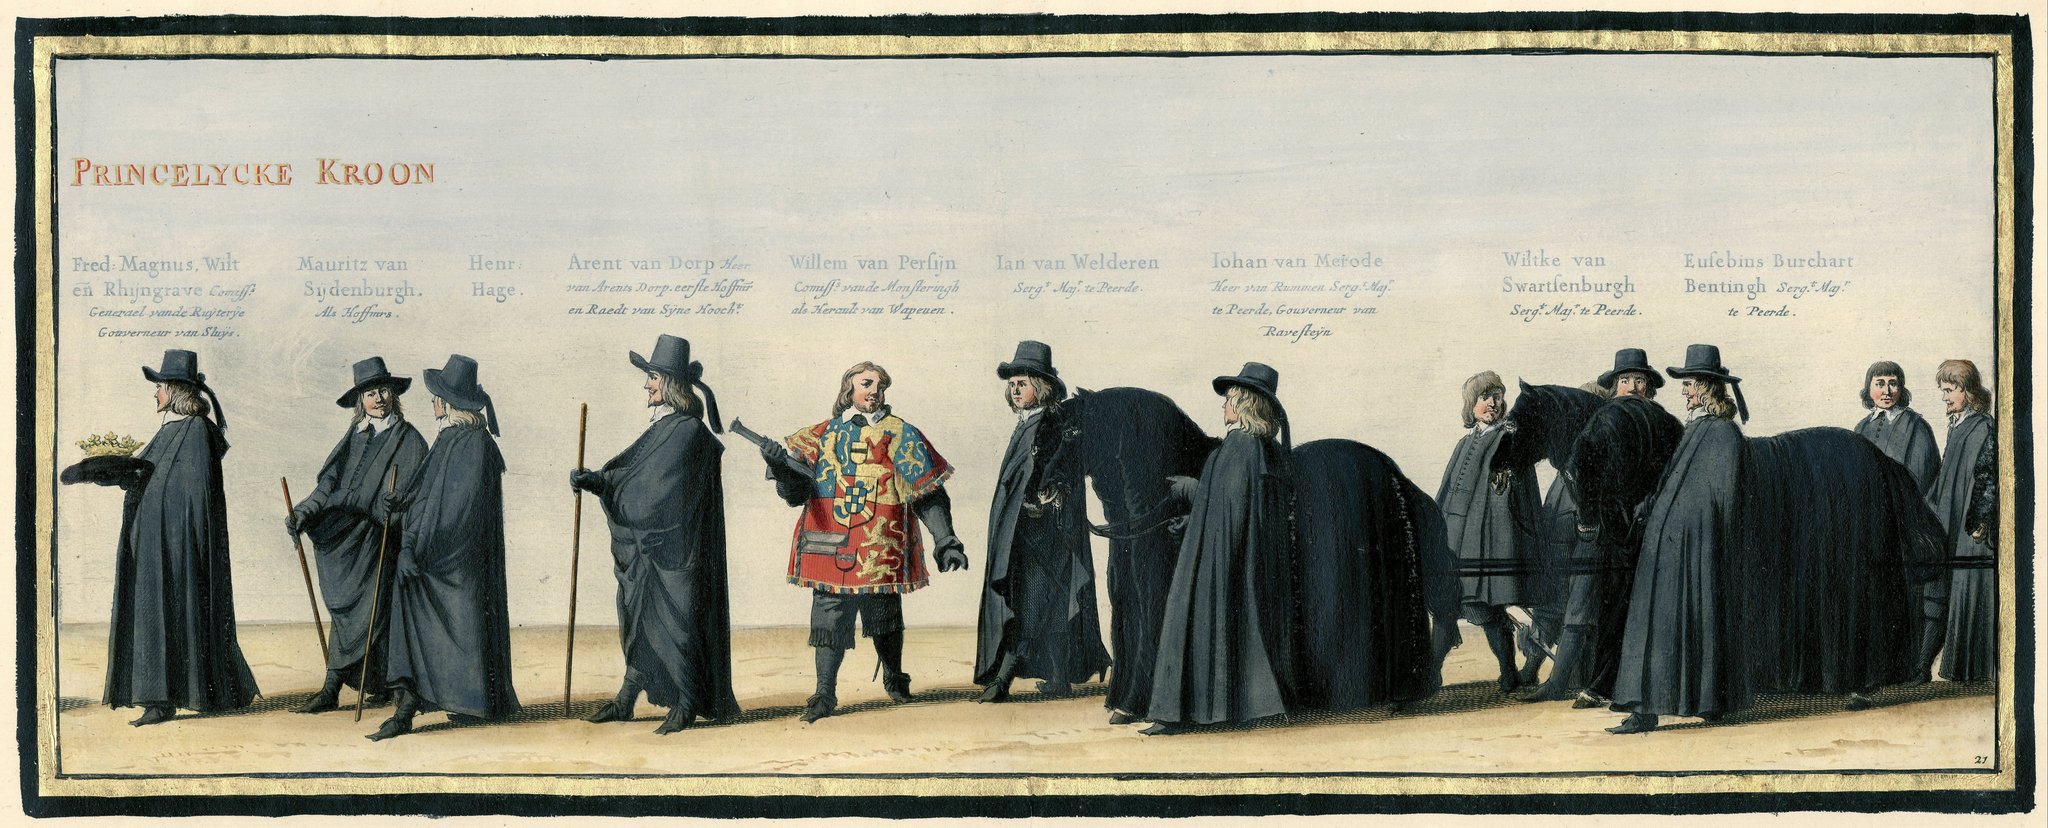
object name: print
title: De begrafenisstoet van Frederik Hendrik, plaat nr. 21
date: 1651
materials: paint, paper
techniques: colour, etching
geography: amsterdam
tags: delft, frederick henry (prince of orange)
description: De begrafenisstoet van Frederik Hendrik, plaat nr. 21. Ingekleurde prent in een omlijsting versierd met goud en ingeplakt in de luxe editie uit ca. 1755 van het boek 'Begraeffenisse van syne hoogheyt Frederick Henrick' van Pieter Post, uitgegeven te Amsterdam in 1651.